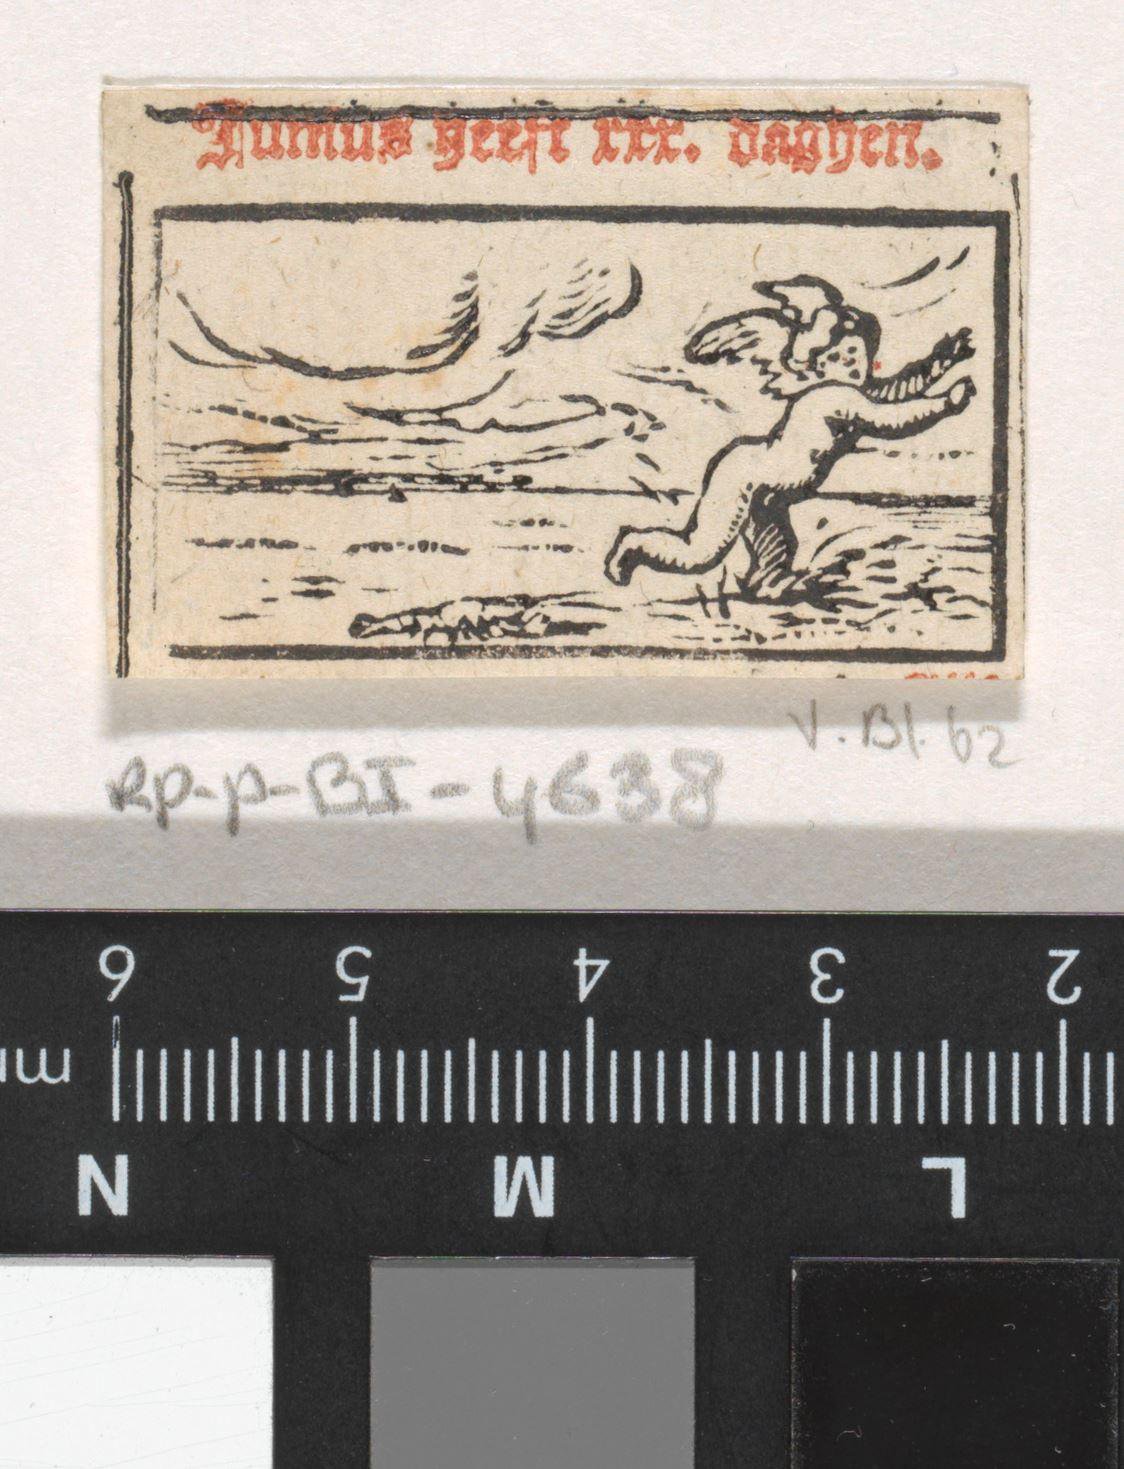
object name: print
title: Maanden van het jaar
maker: dirck de bray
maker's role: draughtsman, painter, print maker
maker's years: 1625-1694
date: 1635-1694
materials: paper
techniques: letterpress printing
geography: netherlands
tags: june and its 'labours' (+ with cancer (june))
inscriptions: collector's mark: Lugt 2228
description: Een putto rent in het water bij het zien van een kreeft. In de bovenmarge een regel Nederlandse tekst.